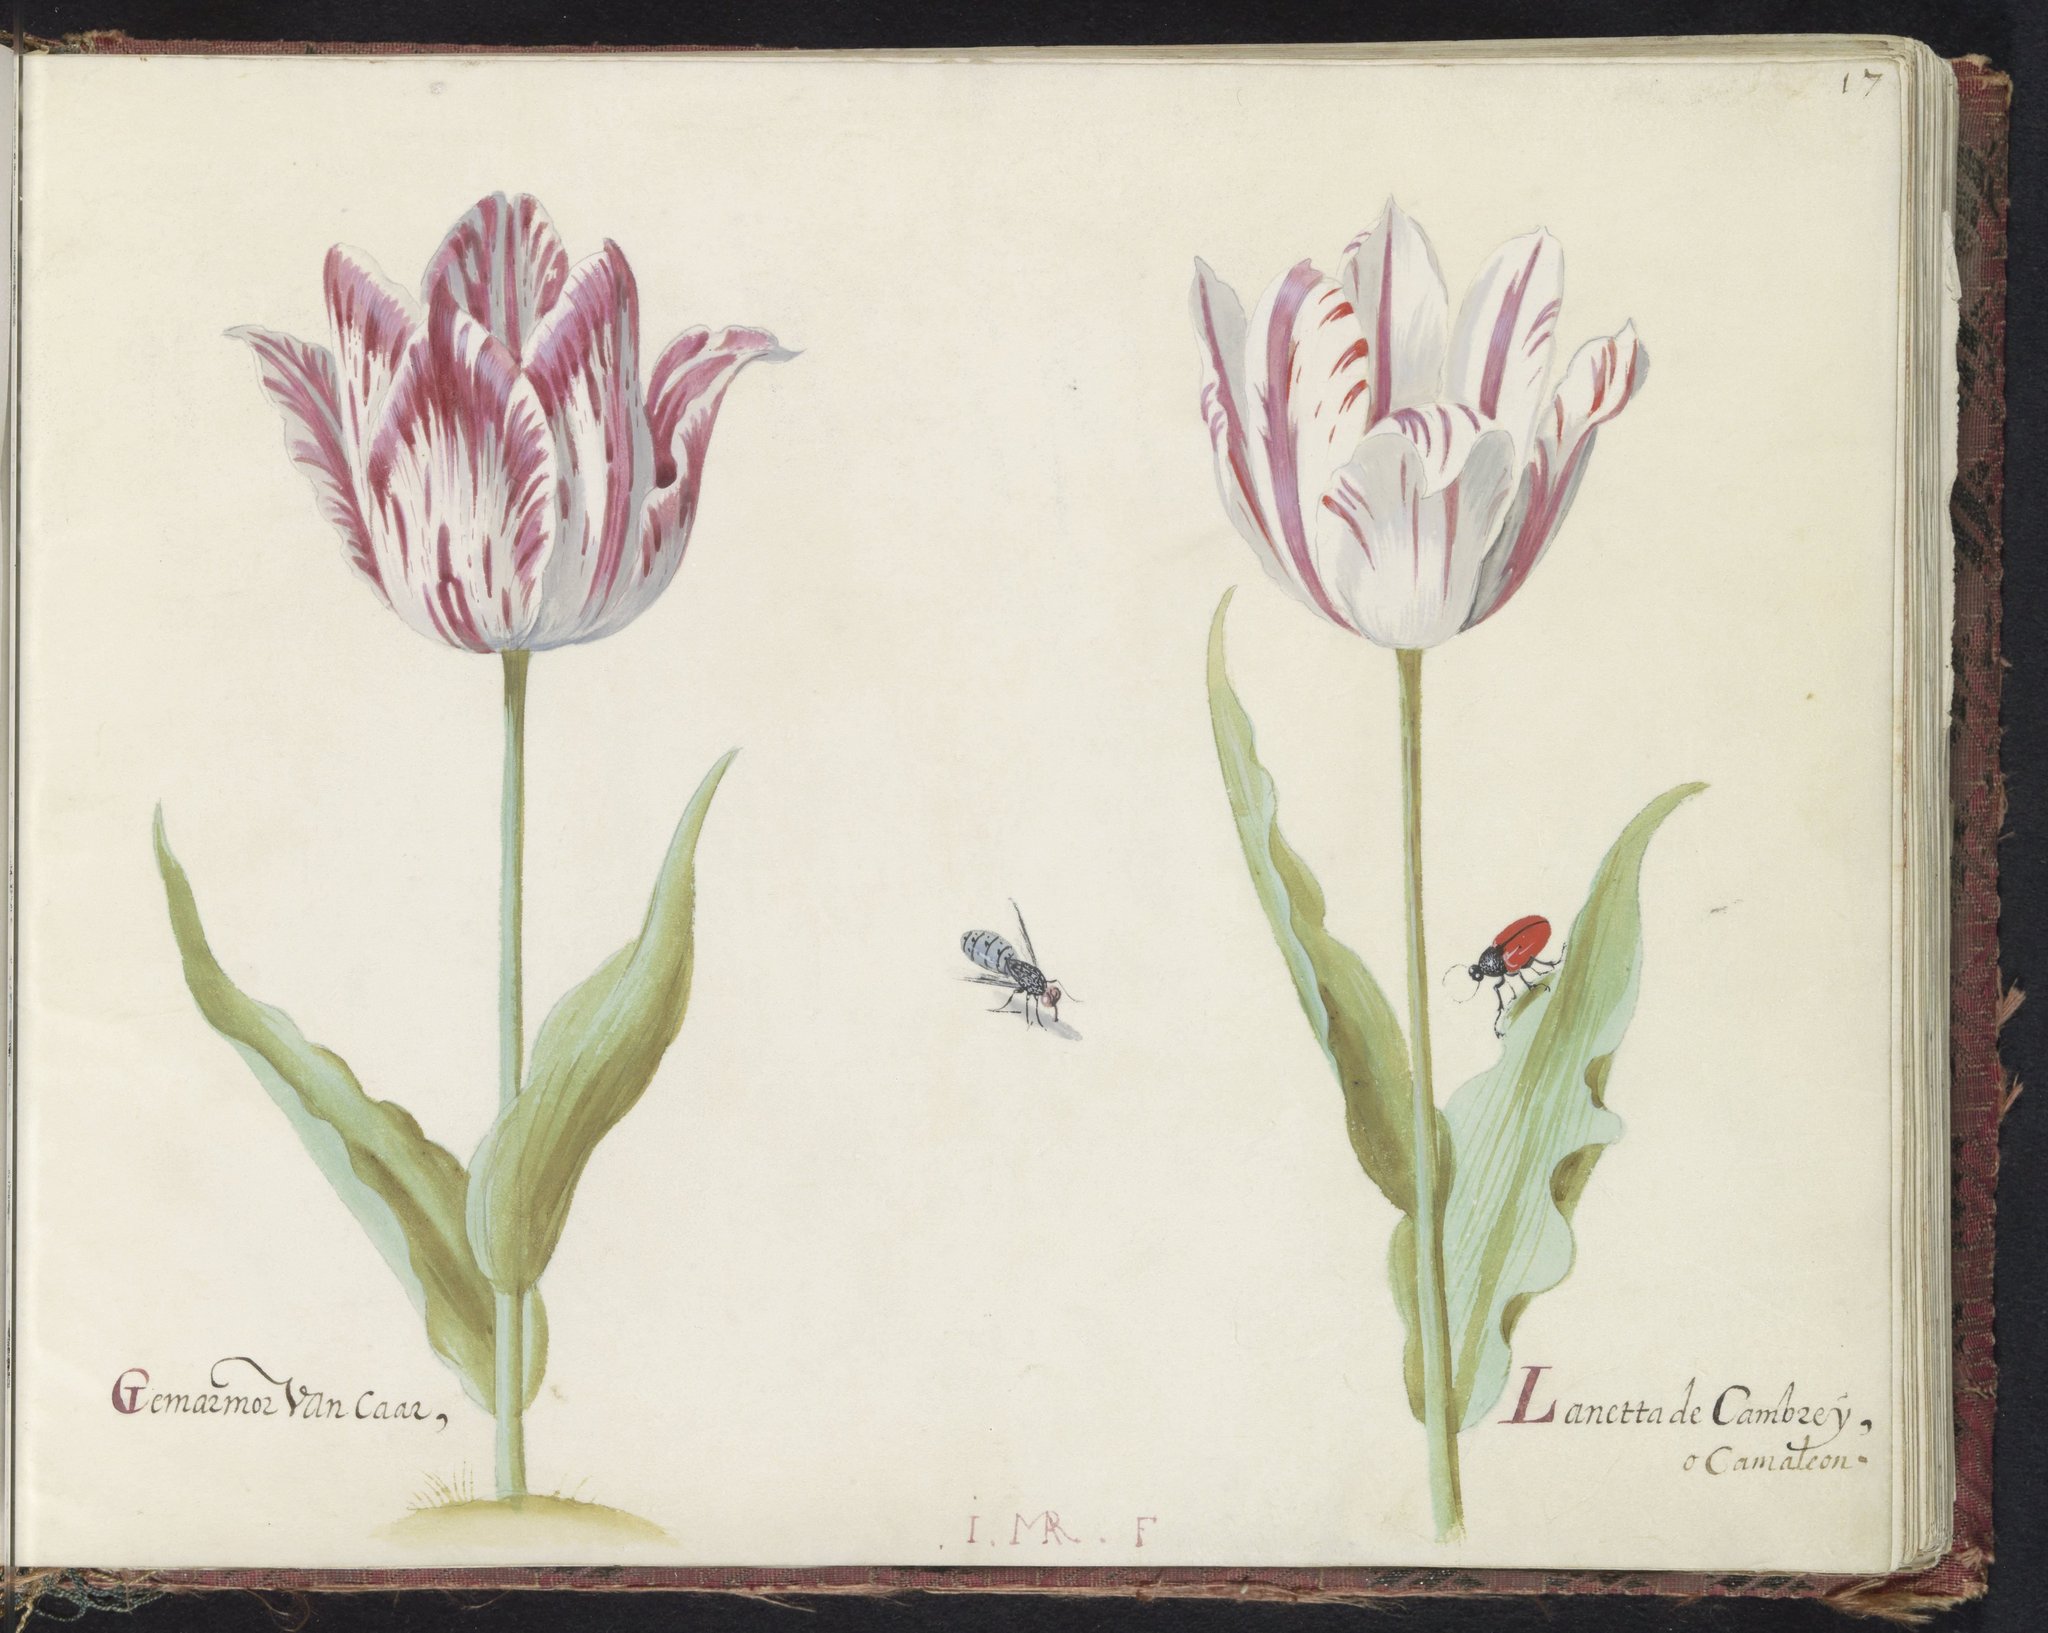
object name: album leaf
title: Gemarmor van Caar / Lanetta de Cambrey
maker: jacob marrel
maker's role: draughtsman, painter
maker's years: 1614-1681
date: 1637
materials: paint, parchment, pencil, watercolor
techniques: brush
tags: flowers: tulip, insects: mosquito, insects: beetle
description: De tekening maakt deel uit van een album.